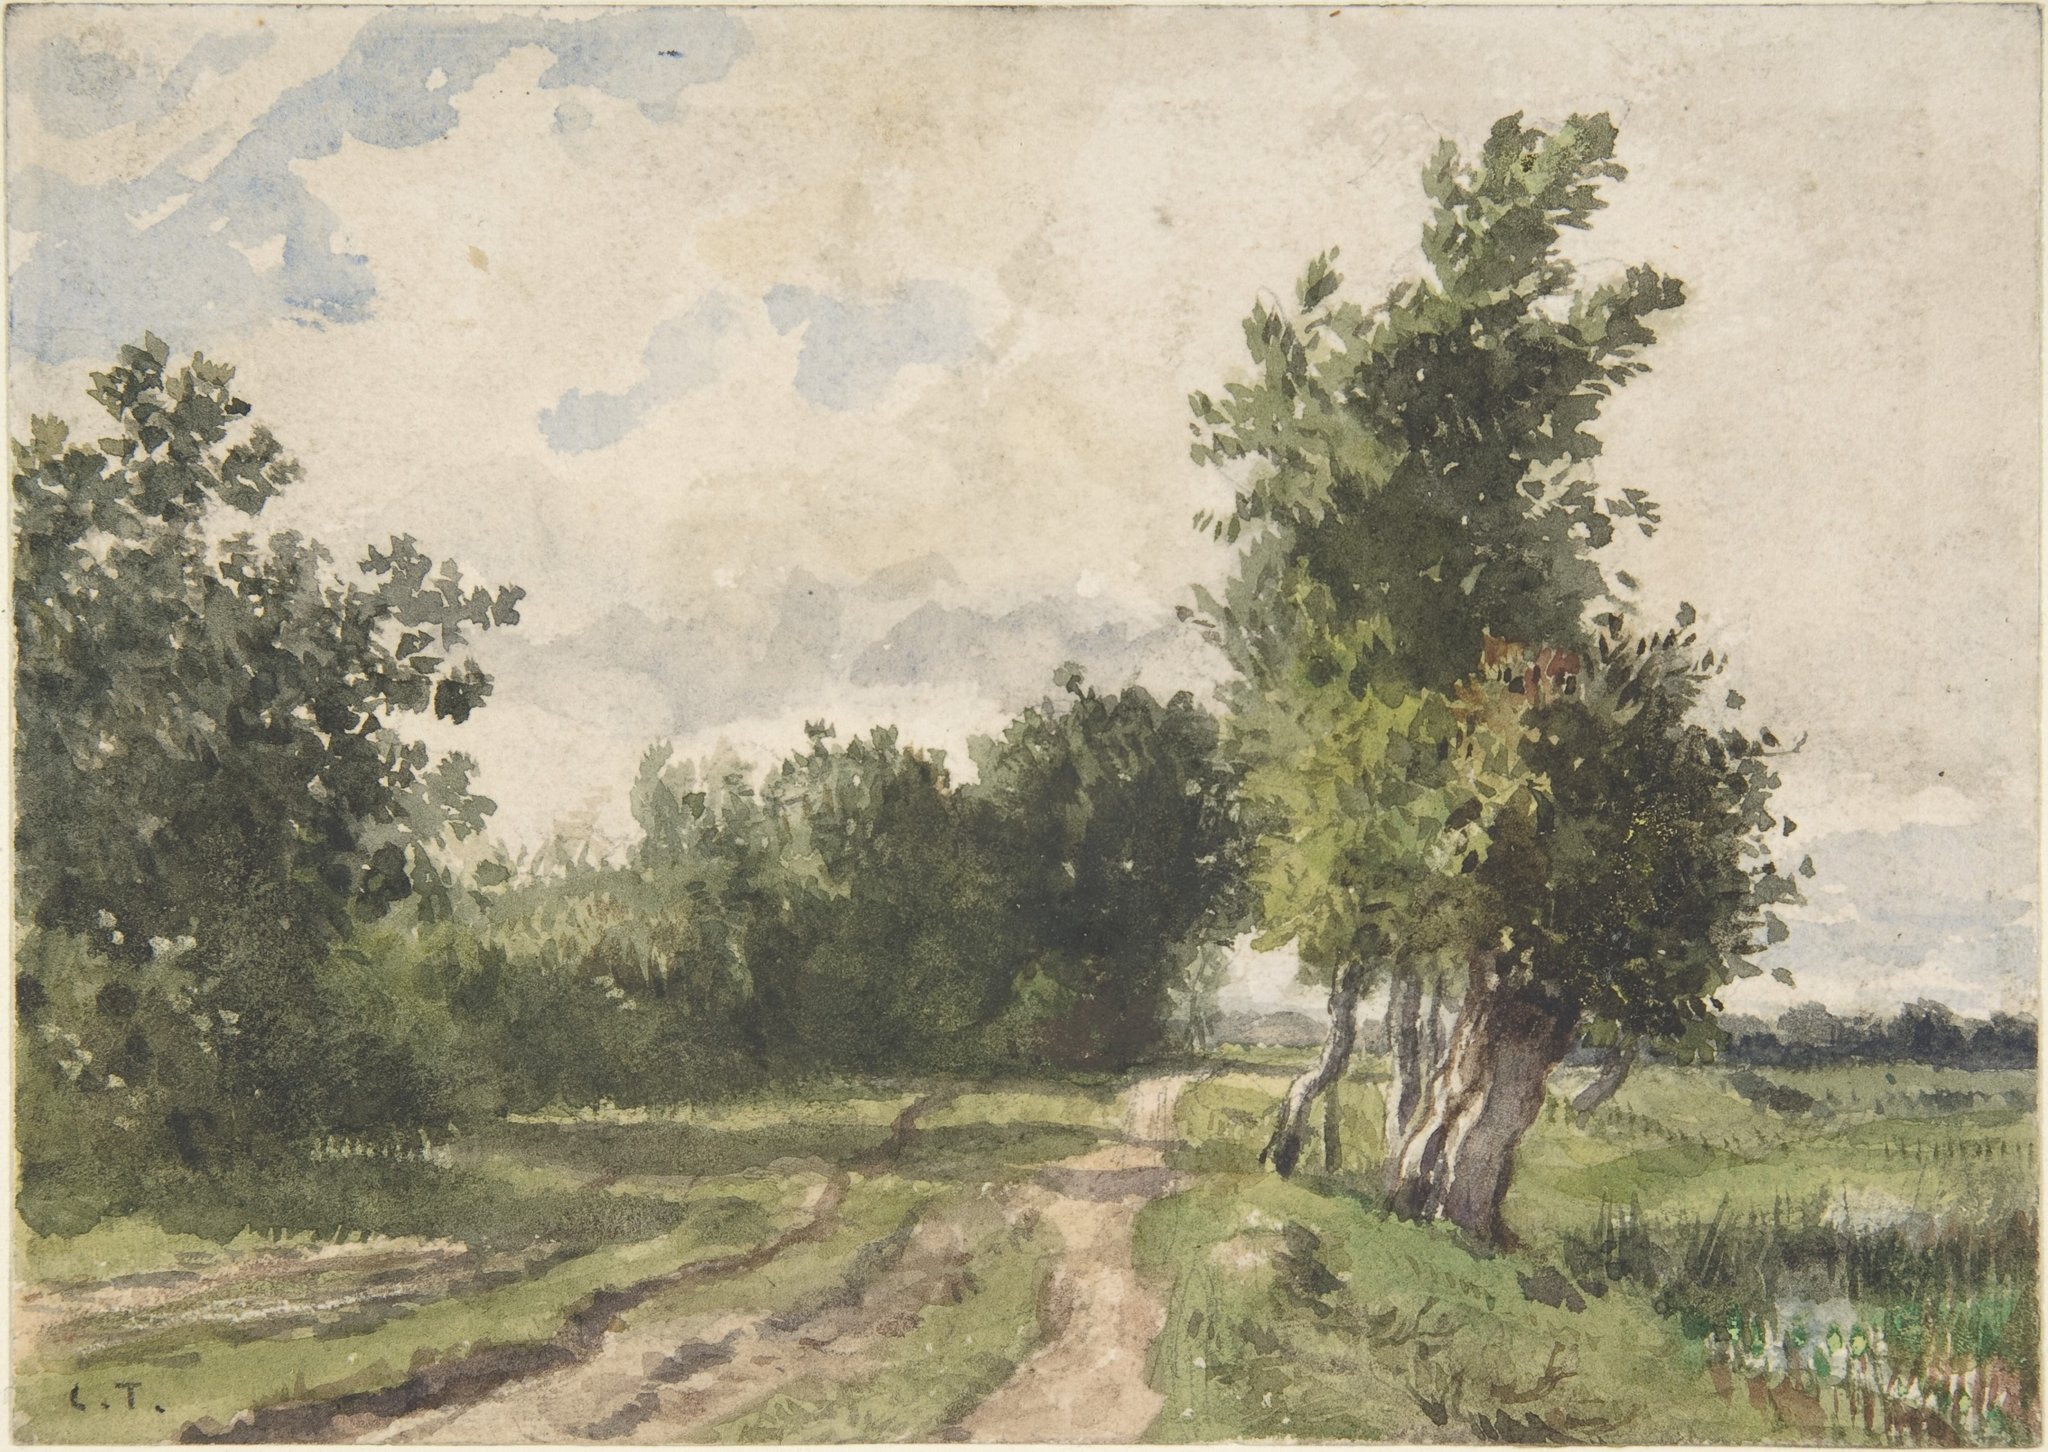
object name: drawing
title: Landscape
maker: constant troyon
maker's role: artist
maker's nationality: french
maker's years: 1810-1865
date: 1825-1865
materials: watercolor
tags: landscapes,trees